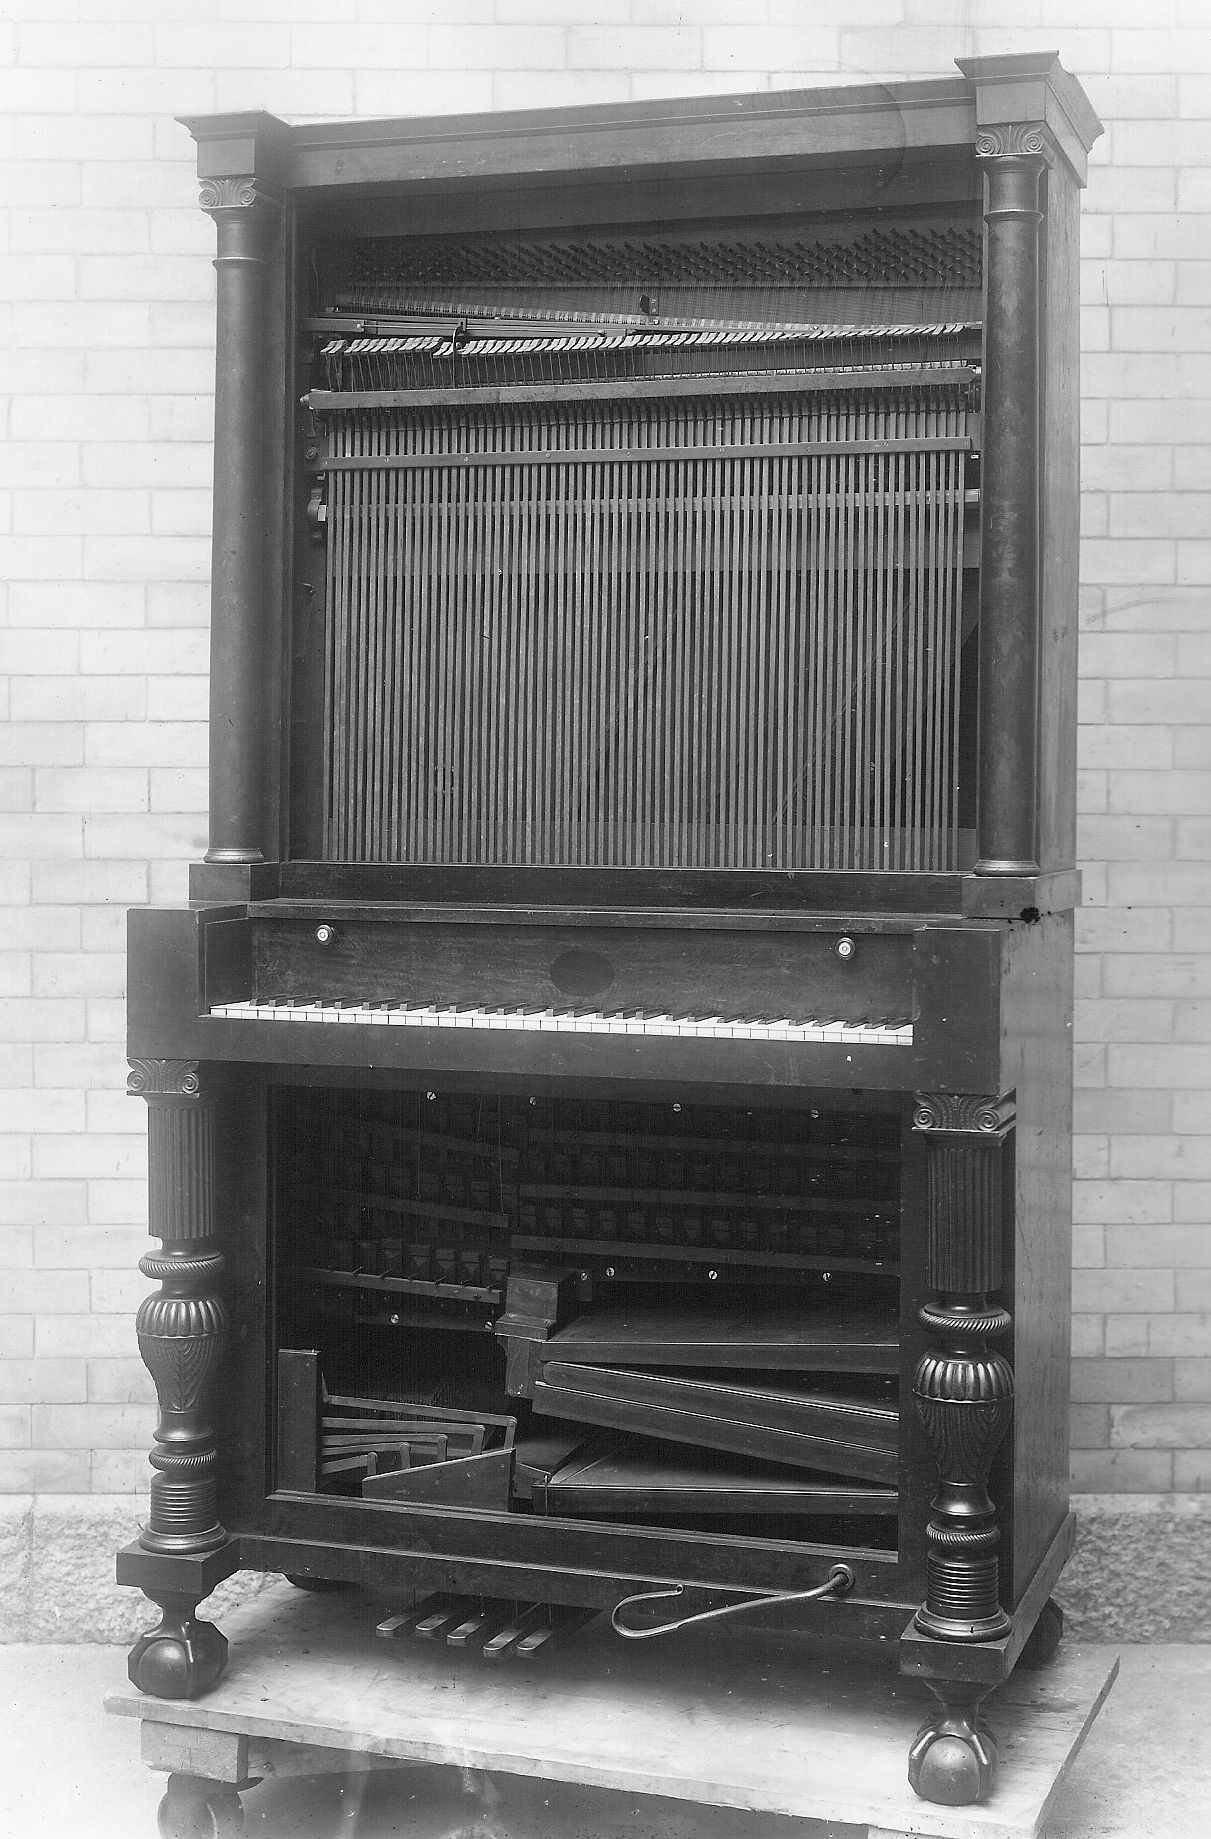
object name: upright piano and reed organ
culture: american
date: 1835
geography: united states